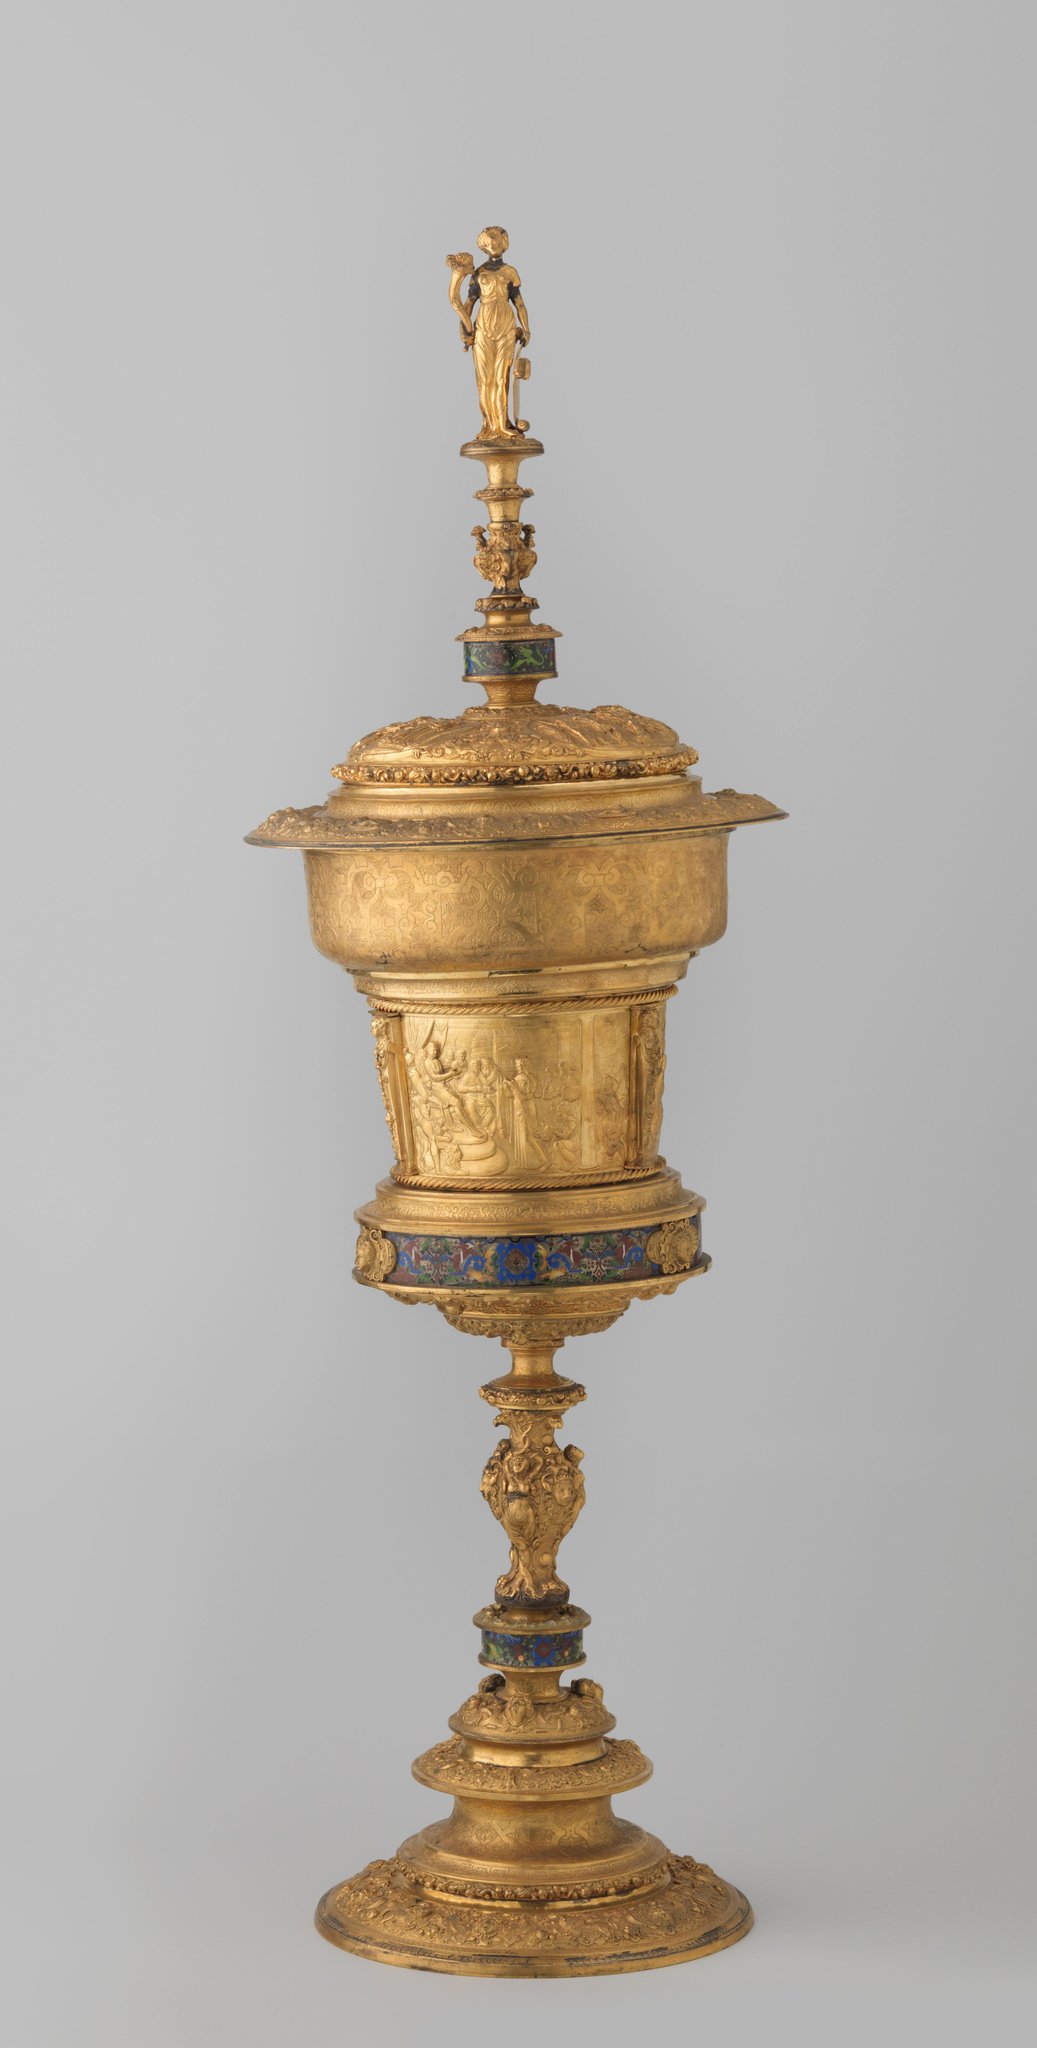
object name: goblet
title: Galvanoplastische reproductie van een bokaal versierd met bandwerk, maskerons en email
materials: copper, silver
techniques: gilding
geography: london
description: Galvanoplastische reproductie van een bokaal versierd met bandwerk, maskerons en bladwerk omgeven door drie banden met email; drie panelen op de wand en drie panelen op het deksel bevatten bijbelse scènes in laagreliëf. Verguld. Met deksel (BK-NM-5317-2).